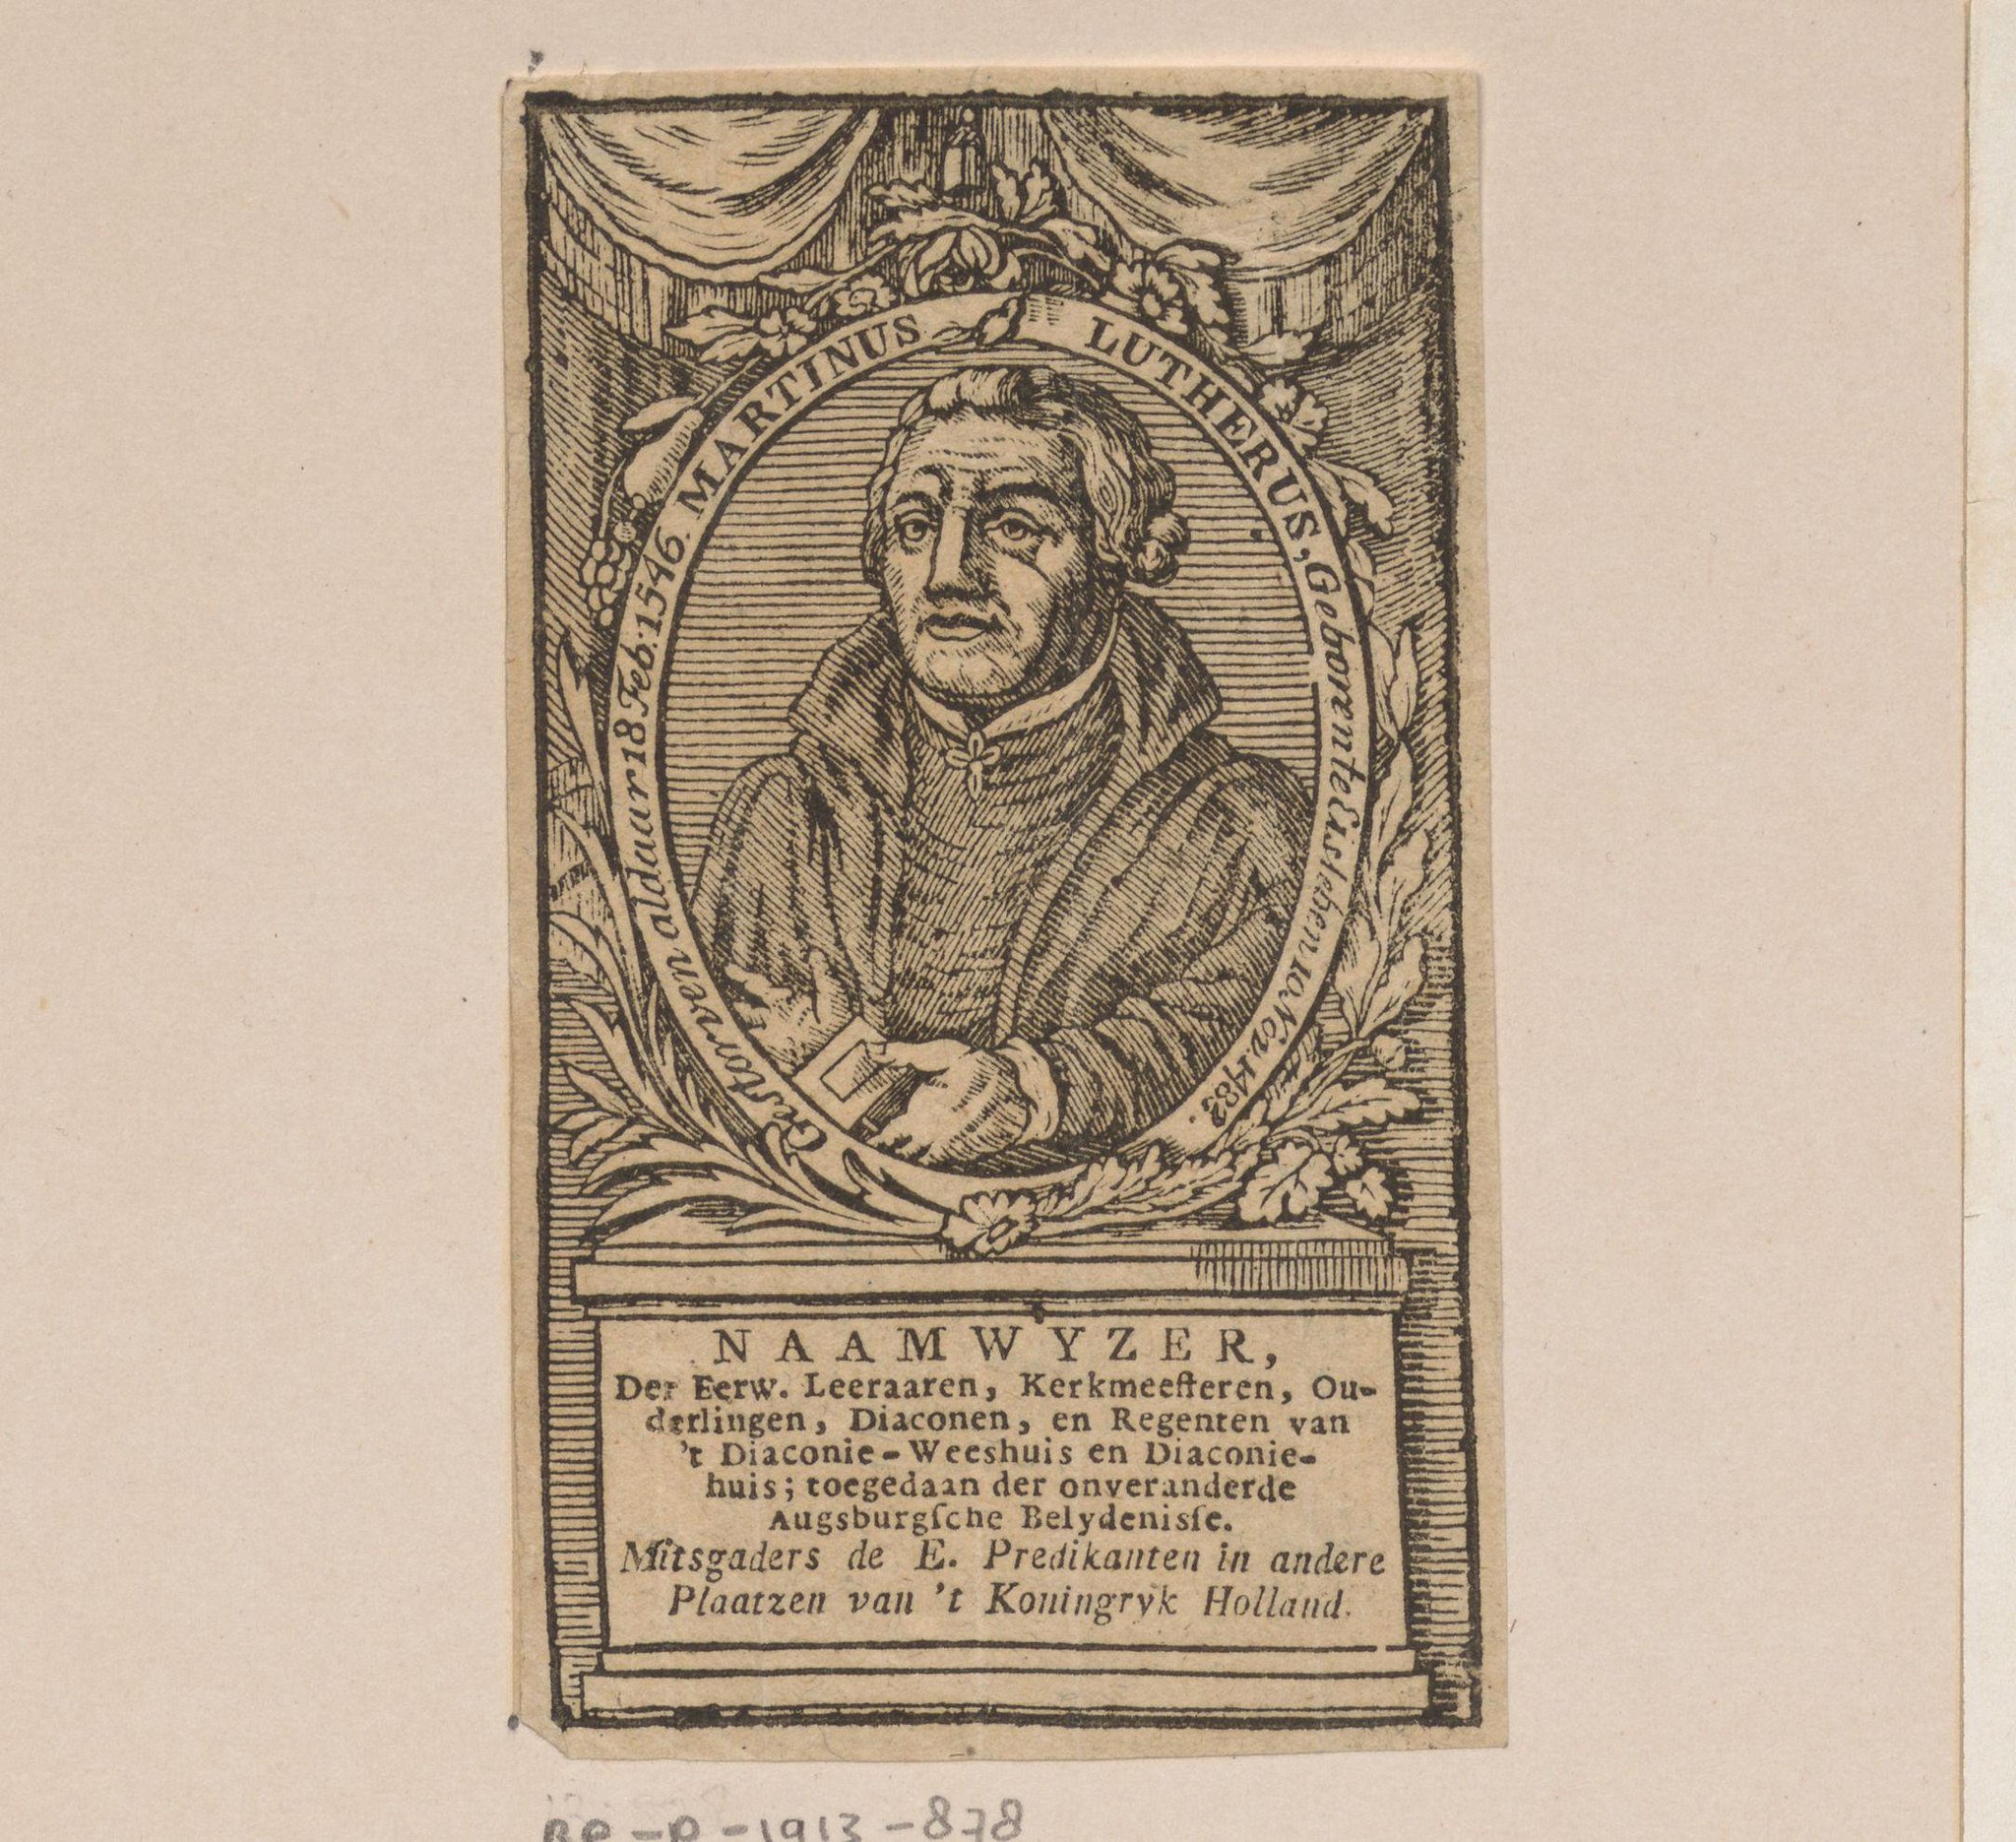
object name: print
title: Portret van Martin Luther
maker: Anonymous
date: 1816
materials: paper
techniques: letterpress printing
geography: northern netherlands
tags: priest, martin luther, theologian, ornament ~ medallion, historical persons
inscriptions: collector's mark: Lugt 2228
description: Met onderschrift in het Nederlands op de sokkel.